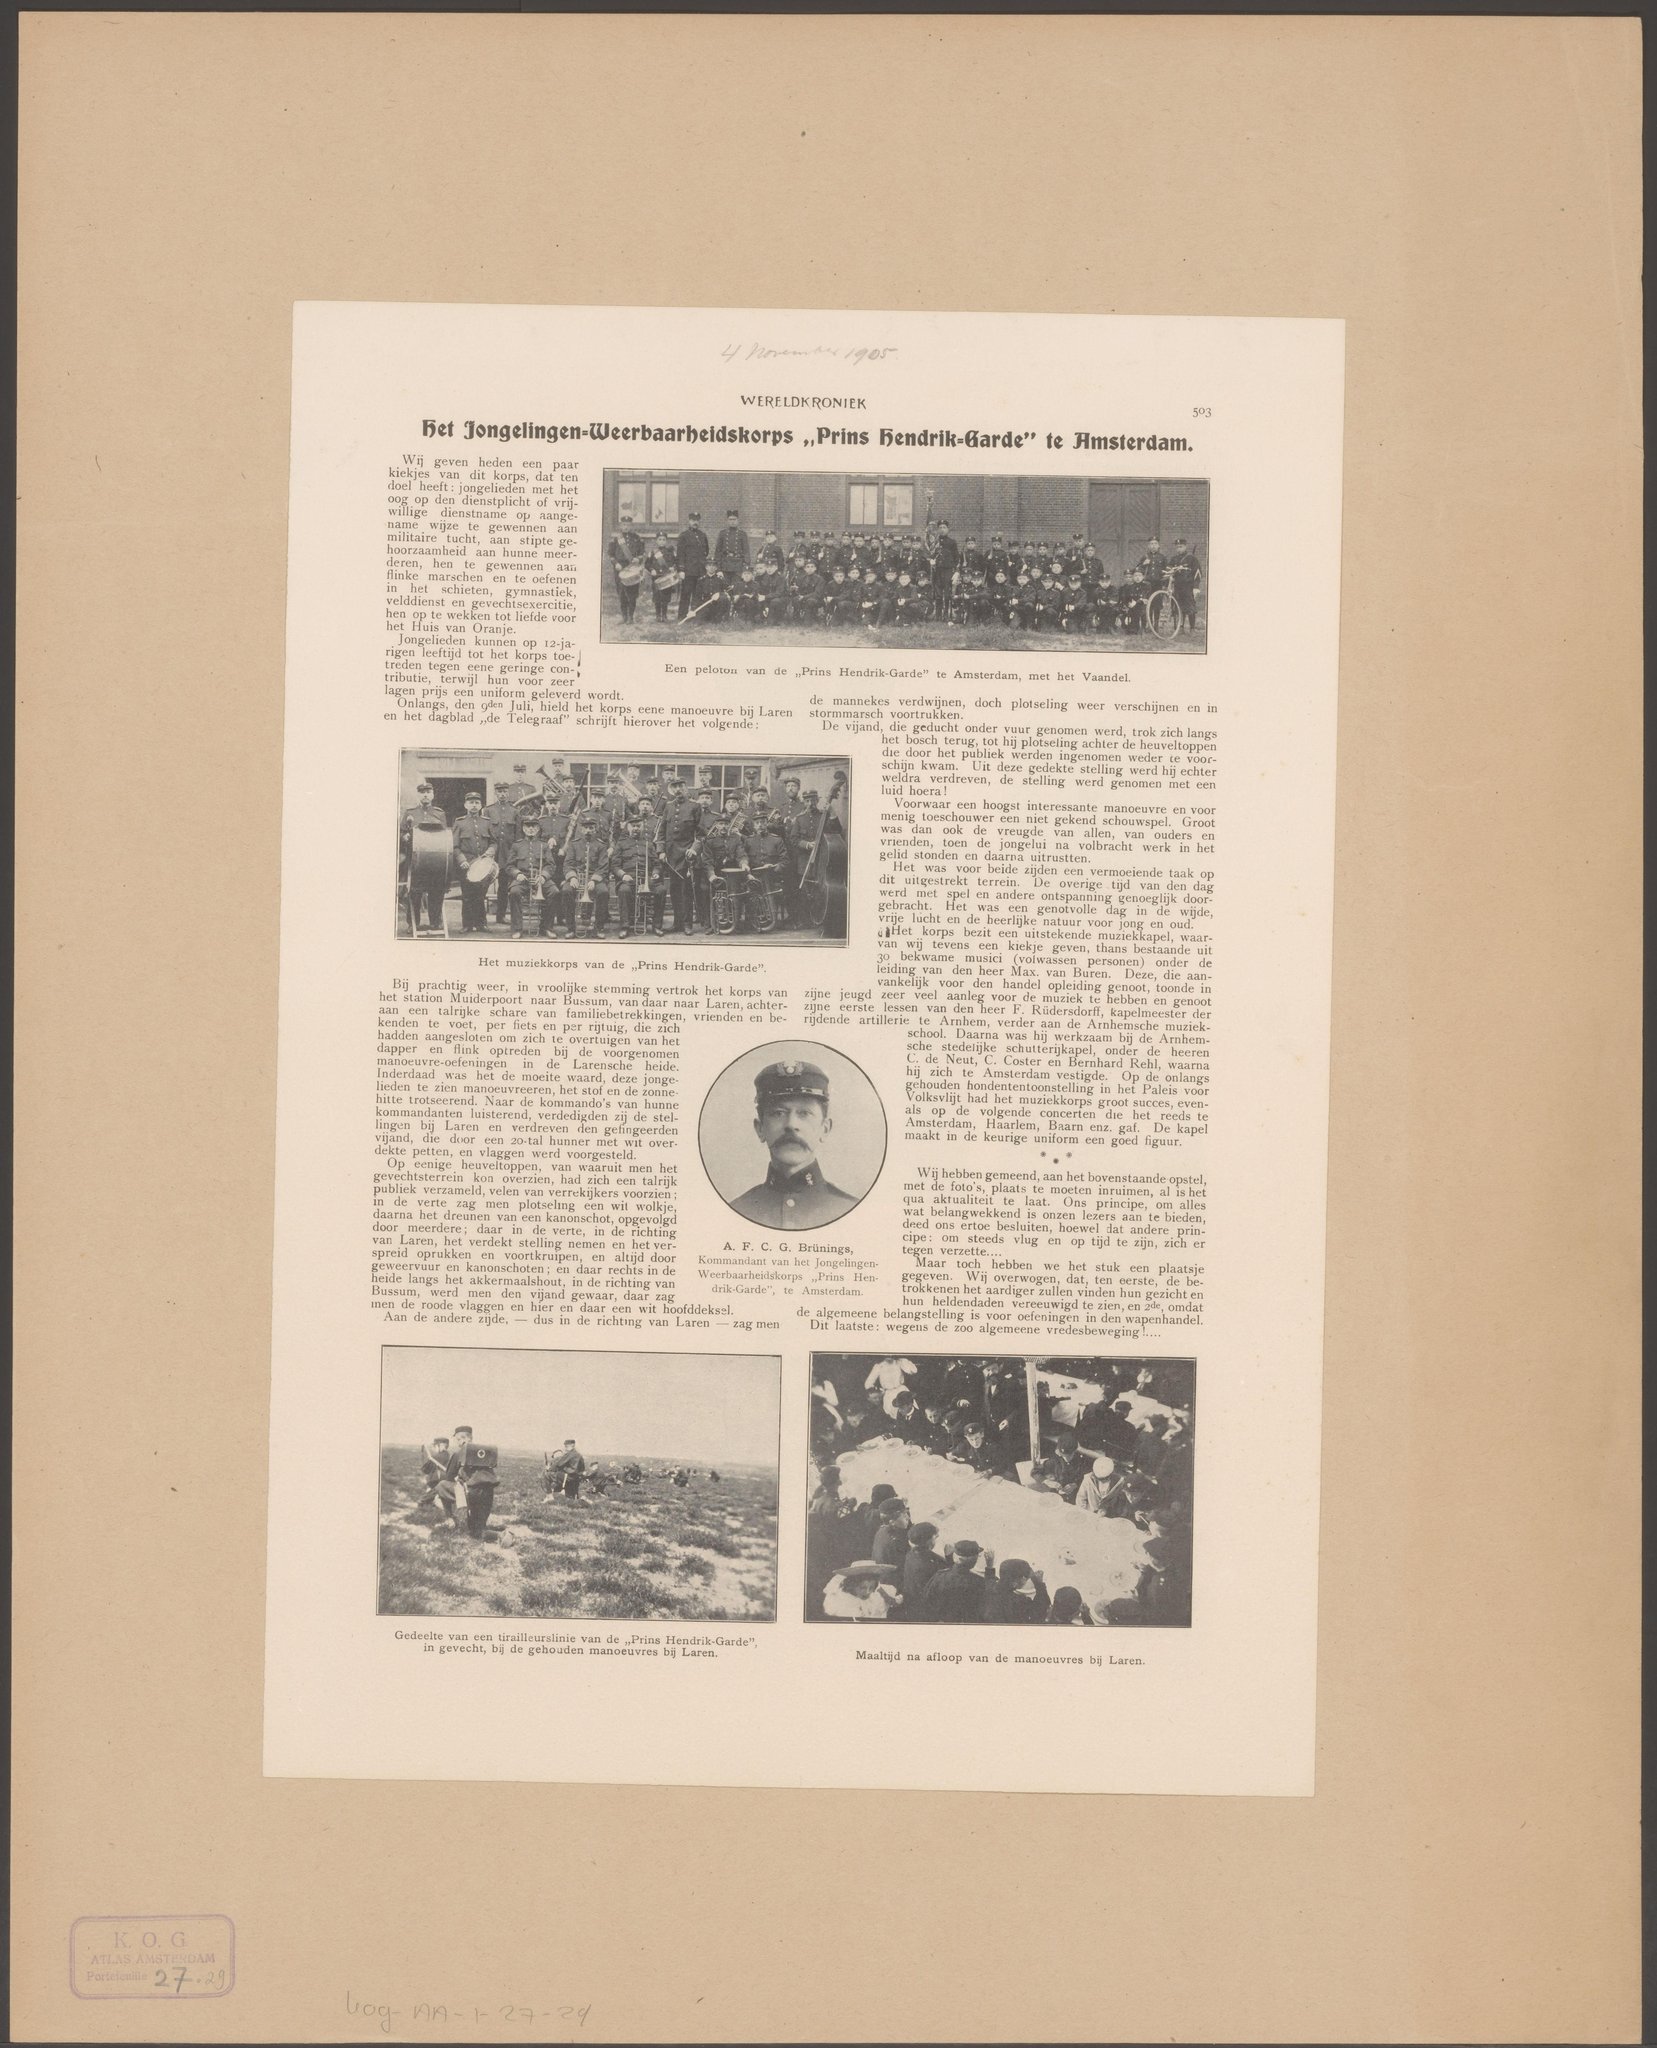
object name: photomechanical print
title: Het Jongelingen-Weerbaarheidskorps "Prins Hendrik-Garde" te Amsterdam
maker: Anonymous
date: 1905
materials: paper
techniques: letterpress printing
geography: netherlands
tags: the company, the unit, the troop ~ military service, canteen ~ the soldier off duty, military training, more than one musician with instrument, amsterdam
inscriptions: collector's mark: Lugt 1641b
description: Onderwerpsrubriek binnen de Atlas Amsterdam: Landmacht: Gebouwen / Herinneringen aan officieren, stadssoldaten / Nationale militie / (diverse korpsen) / Padvinders / Parade.